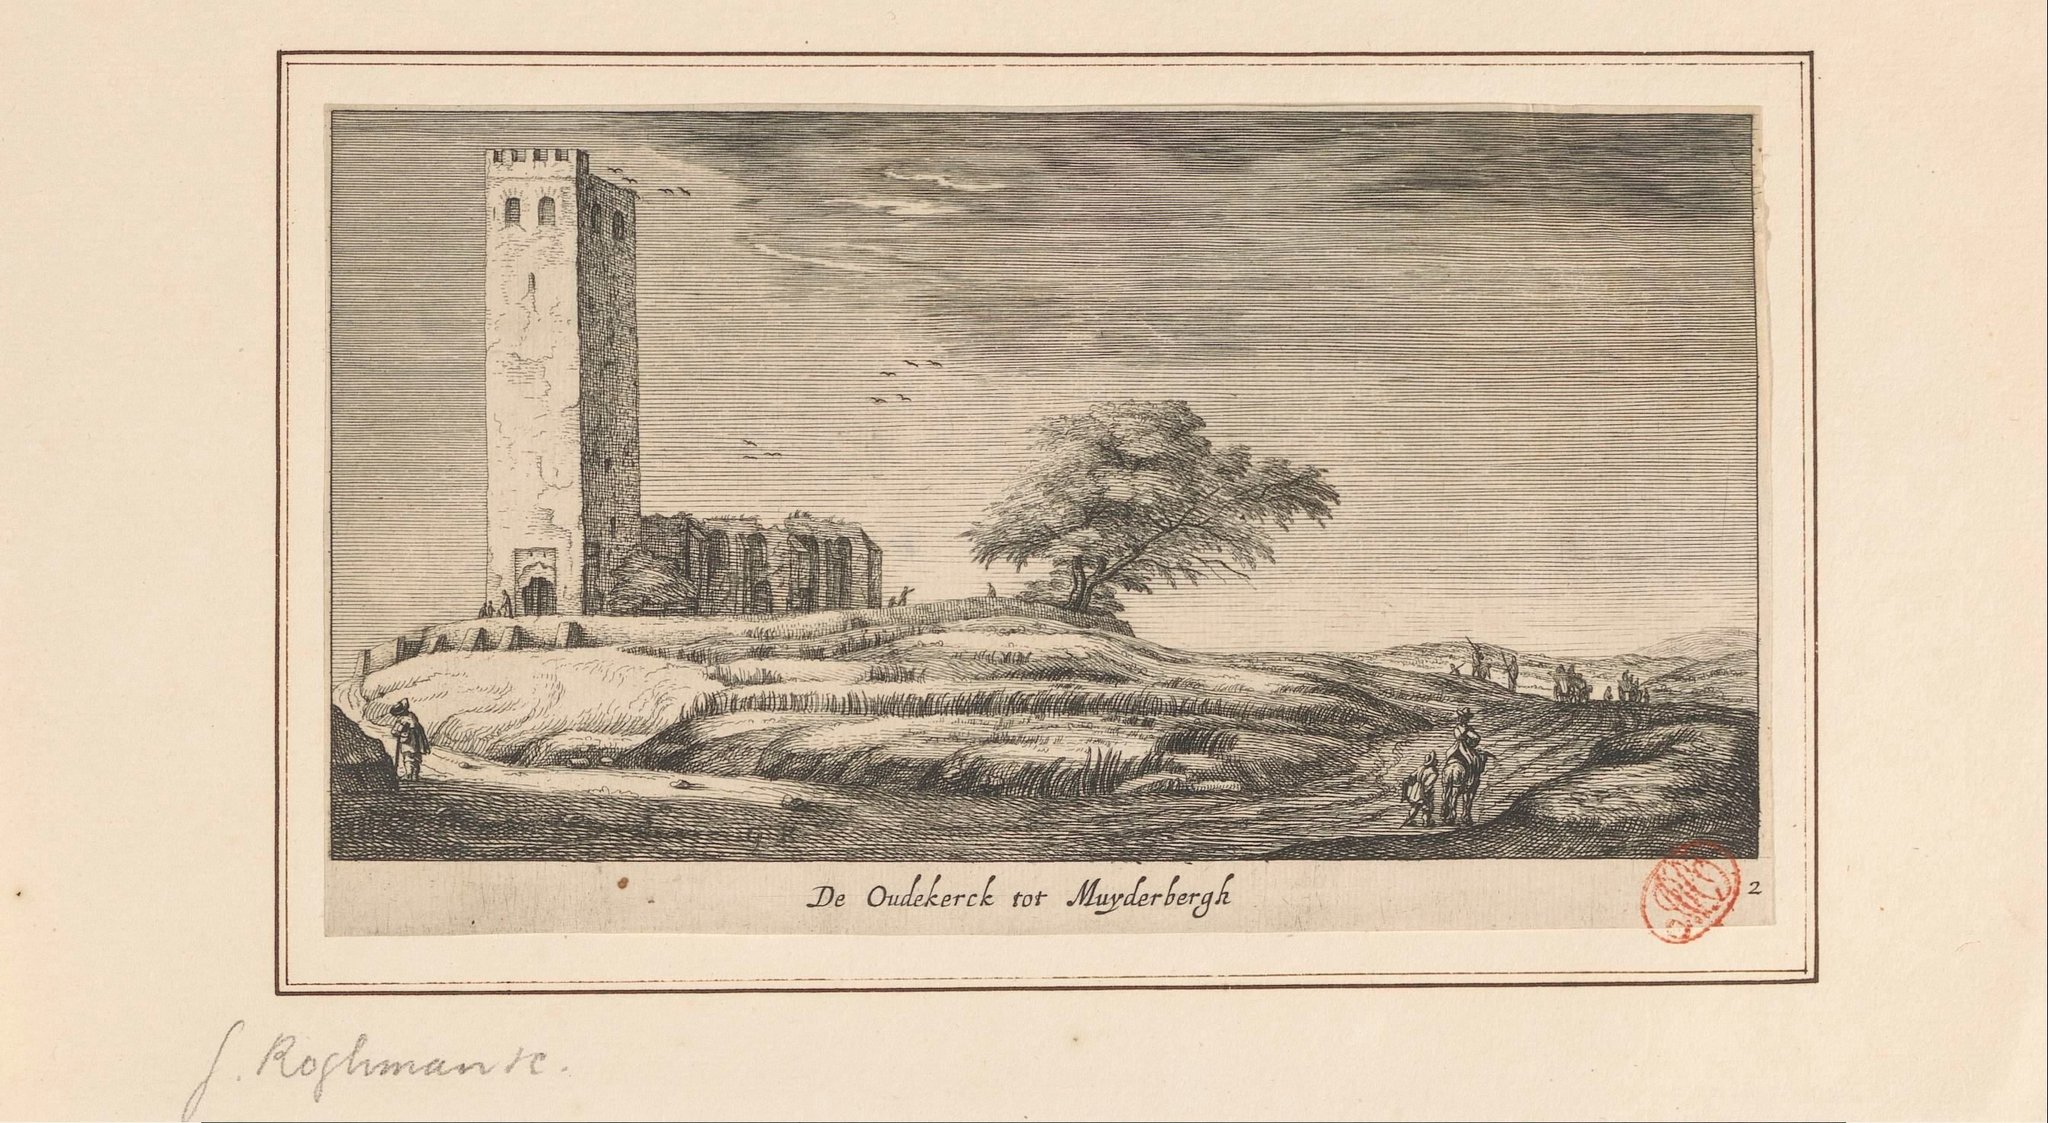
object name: print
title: Oude kerk in Muiderberg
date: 1637-1652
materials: paper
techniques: engraving, etching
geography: amsterdam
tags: church (exterior)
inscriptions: collector's mark: Lugt 195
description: Gezicht op de gedeeltelijk geruïneerde kerk (tegenwoordig Kerk aan Zee genoemd) te Muiderberg. De prent is deel van een serie landschappen met dorpen rondom Amsterdam. Rechtsonder genummerd: 2.